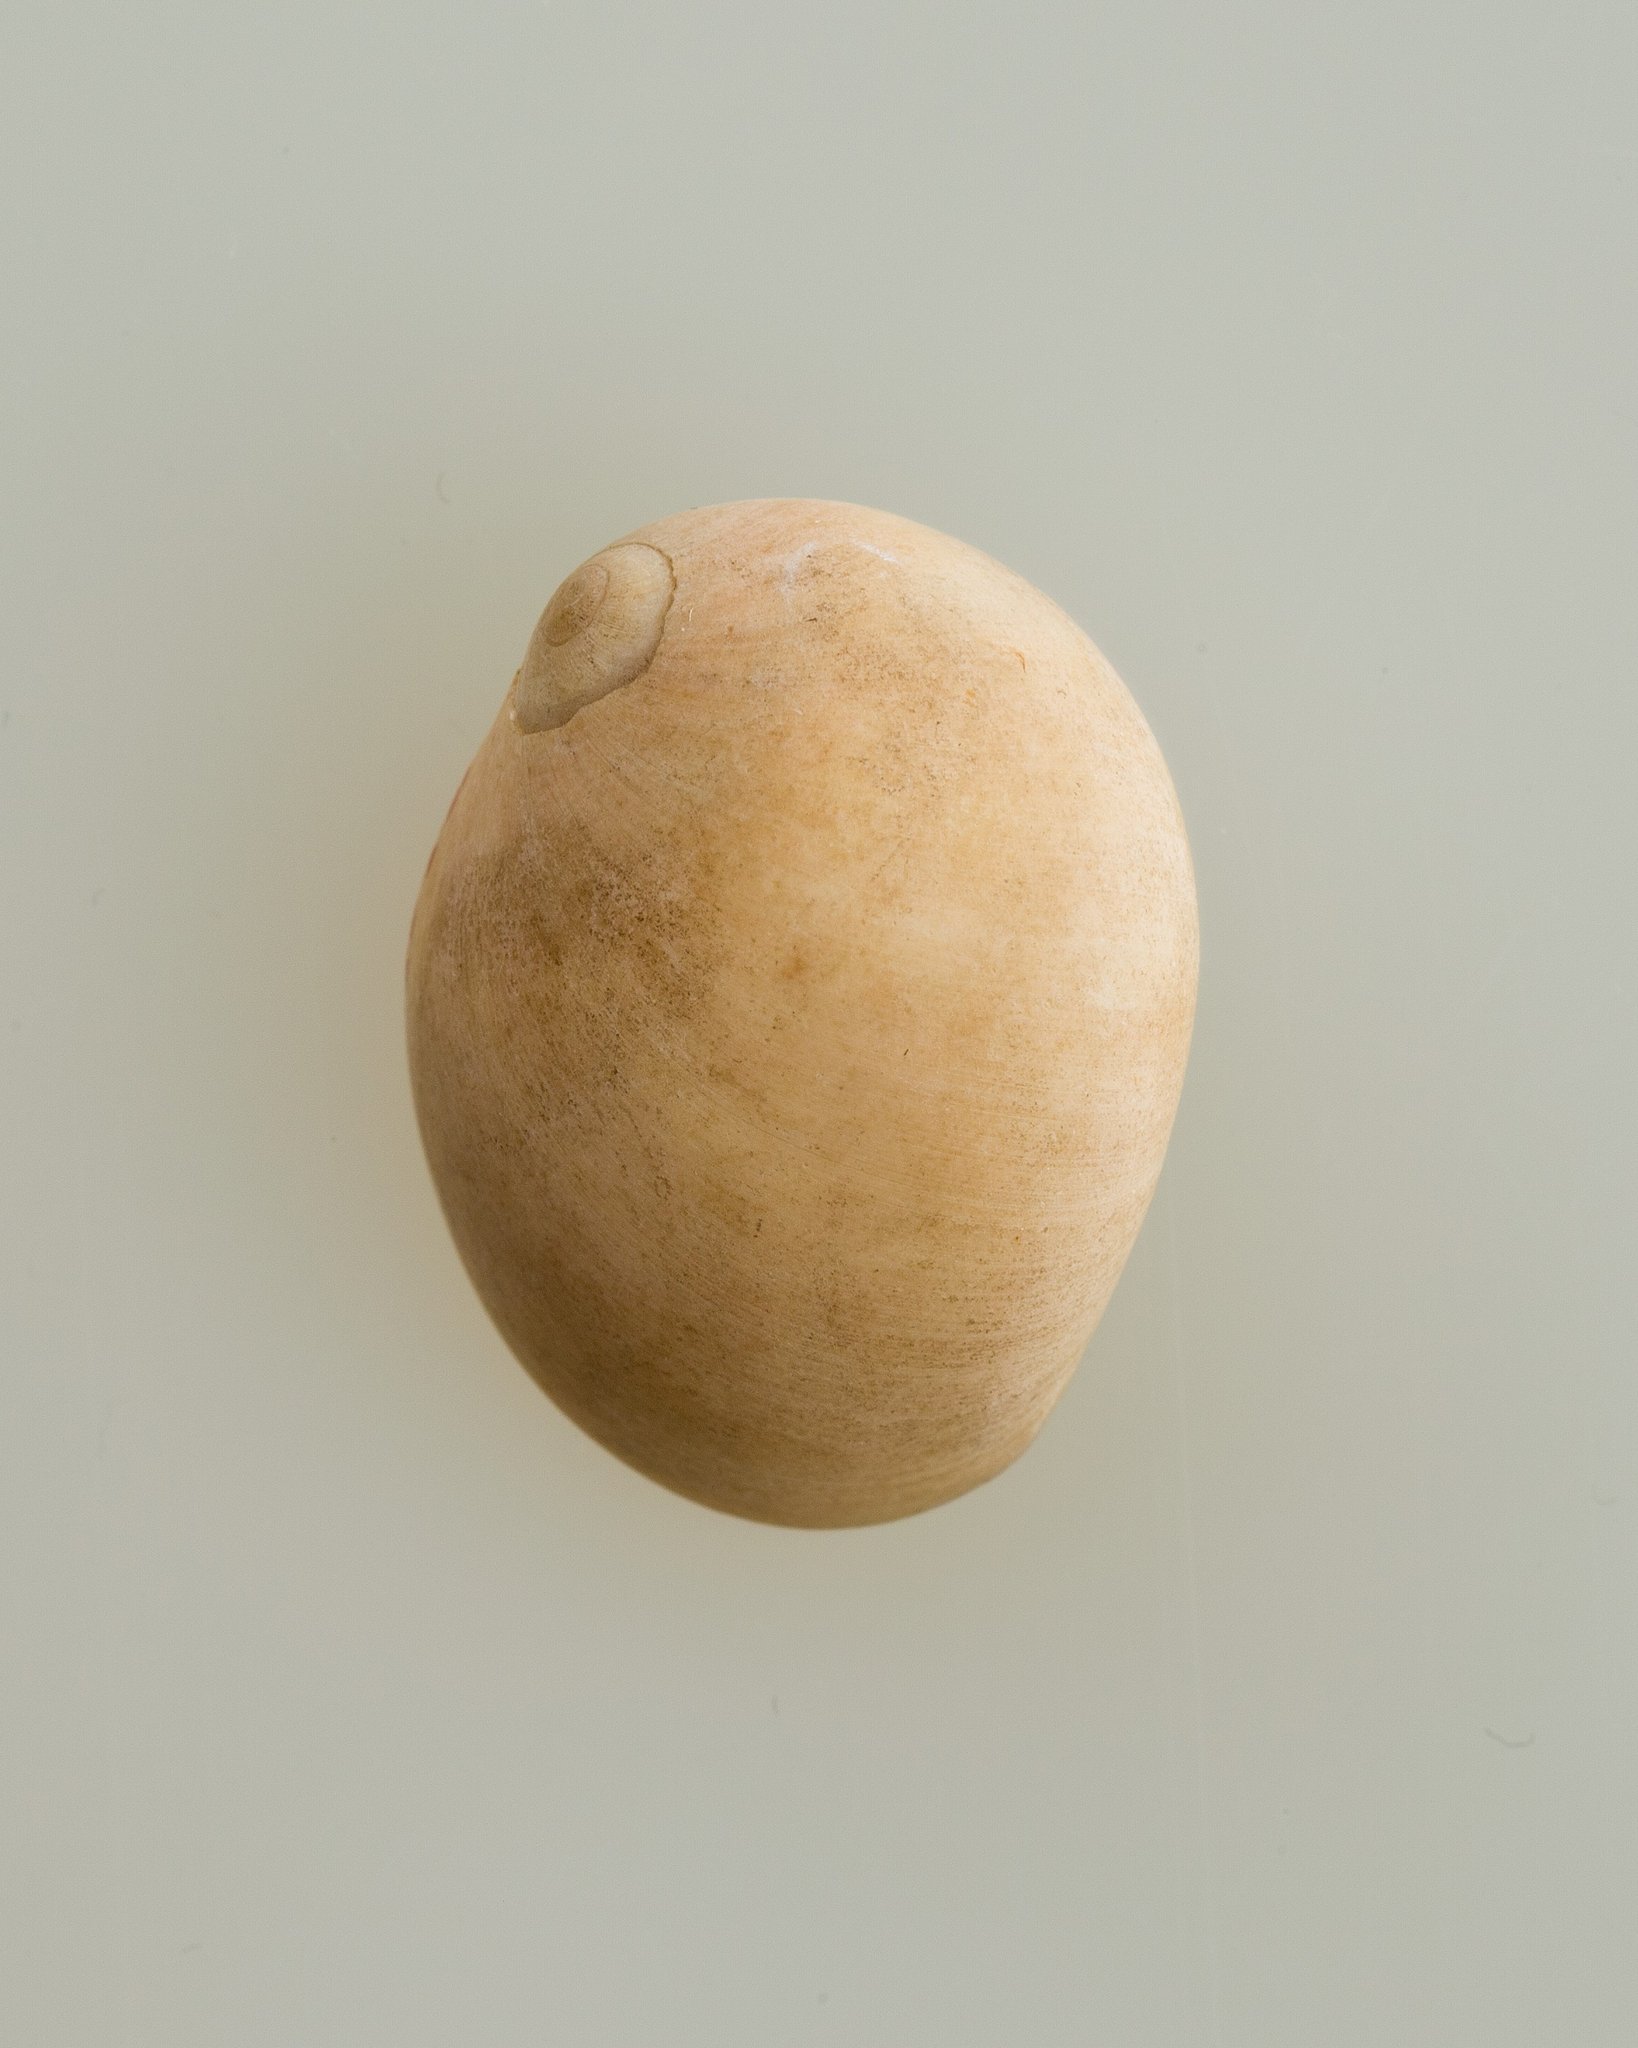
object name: pendant, shell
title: Shell pendant or bead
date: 3850-2960 BCE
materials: shell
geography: egypt